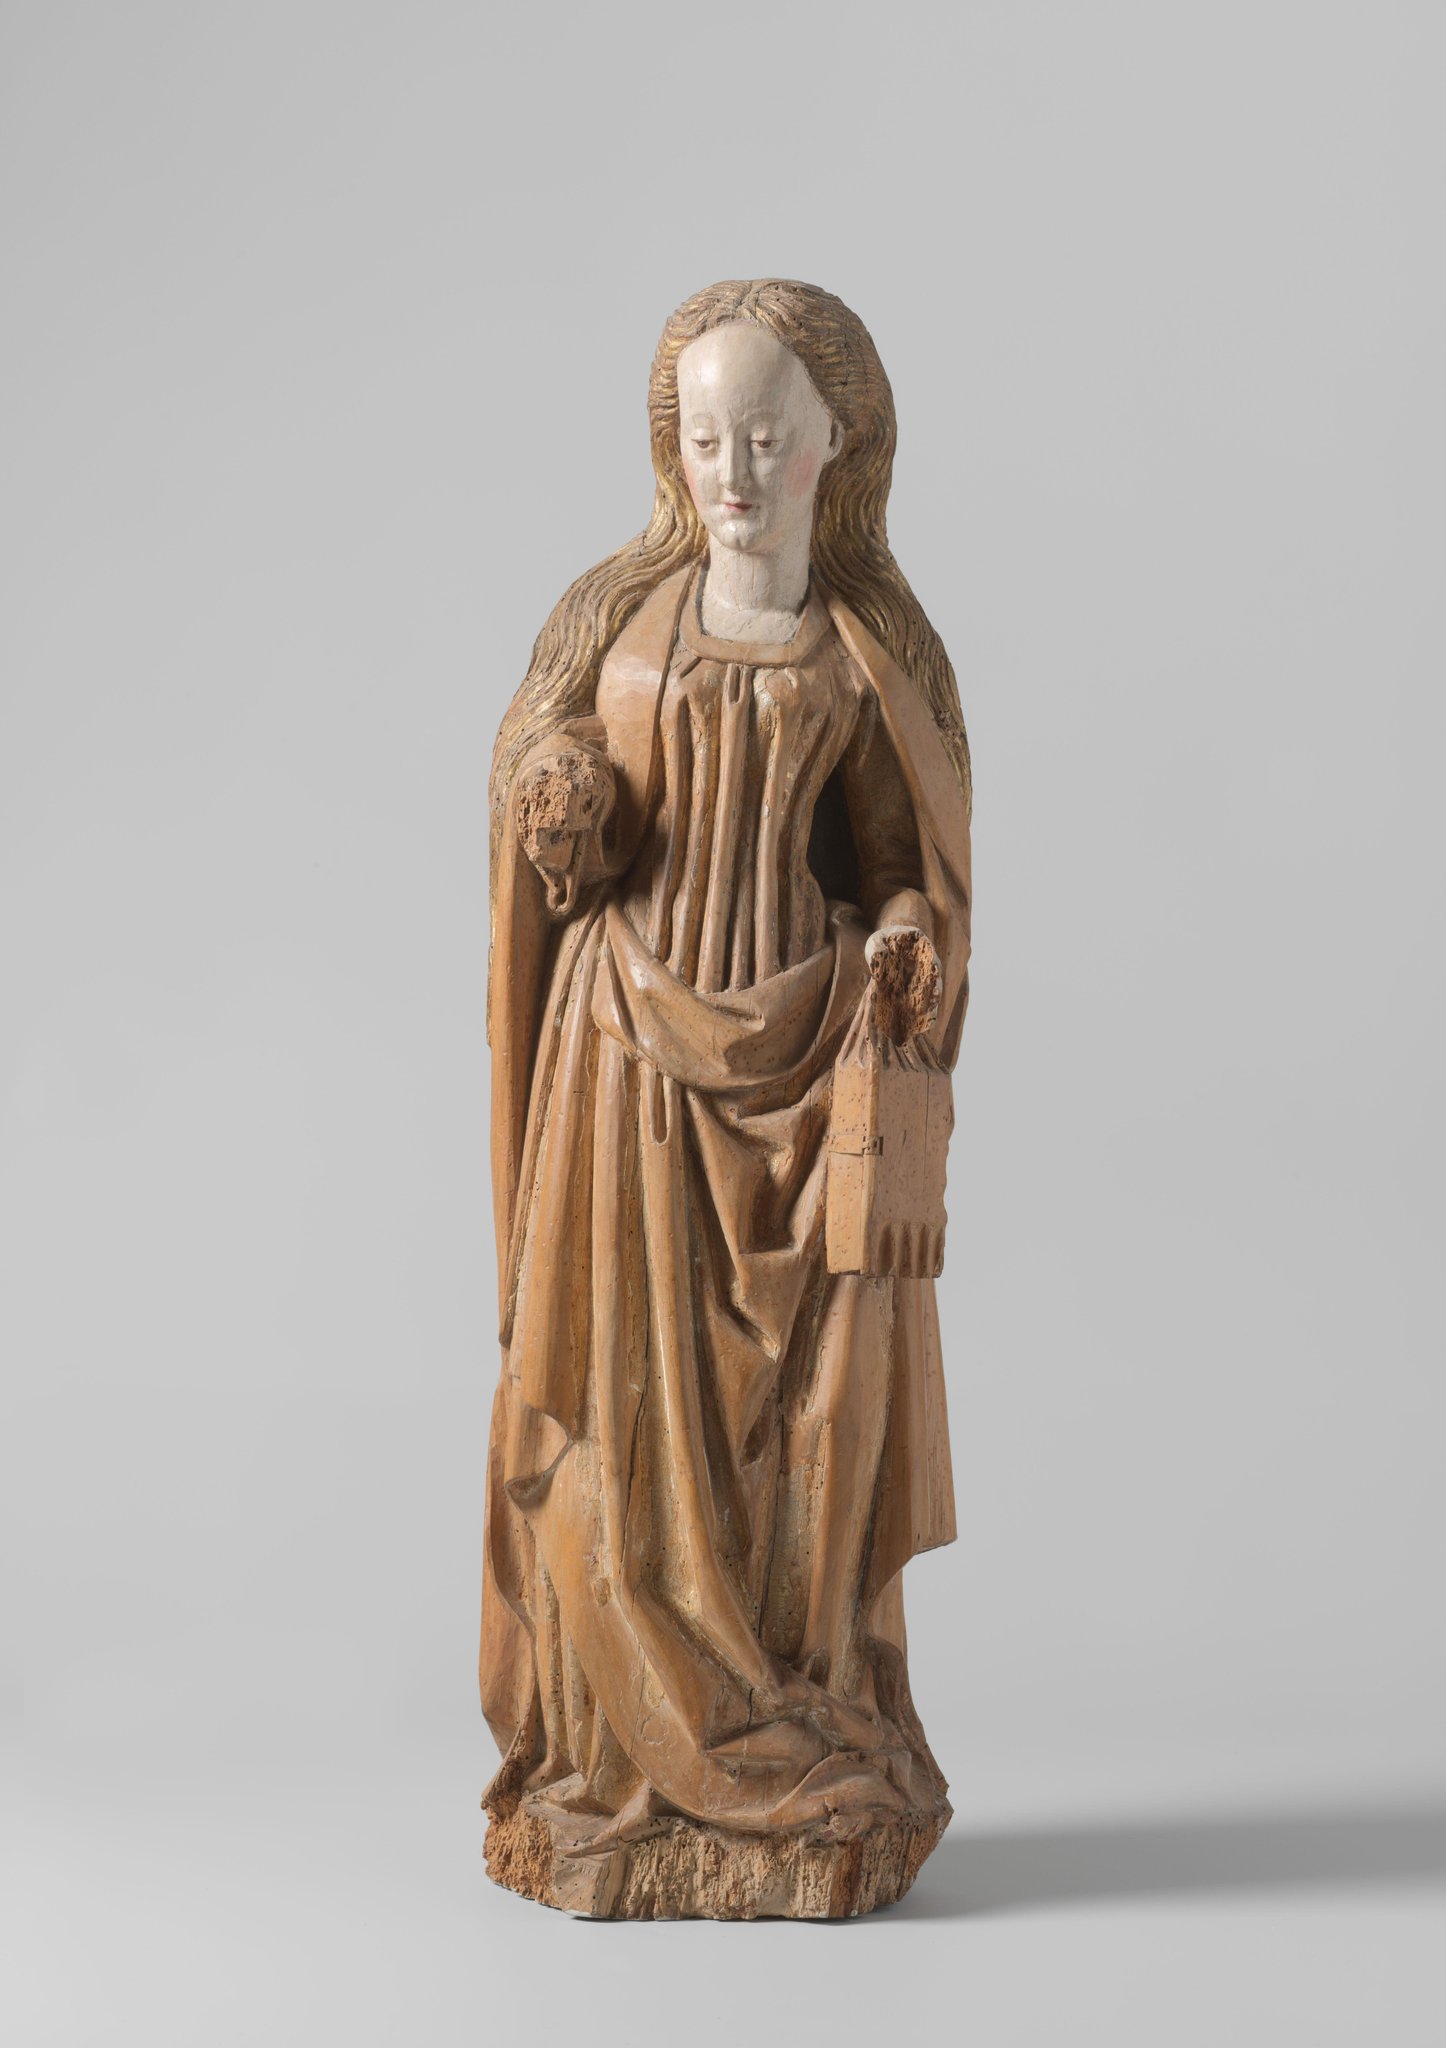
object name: sculpture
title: Female Saint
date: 1470-1480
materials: wood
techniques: polychromy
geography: north brabant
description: Zij staat op een grondje met gebogen linkerknie, heeft de rechter onderarm naar voren en houdt in de linkerhand (die verloren ging) een boek bij de buidel. Van het hoofd, dat iets naar links is gewend, valt het gescheiden haar tot over de schouders. Over een dun onderkleed, dat bij de hals tevoorschijn komt, een lang gewaad, dat aan de zoom van de halsuitsnijding in evenwijdige plooien voor borst en middel valt, maar verder schuil gaat achter de mantel die, naar links toegeslagen, onder de armen is opgenomen.